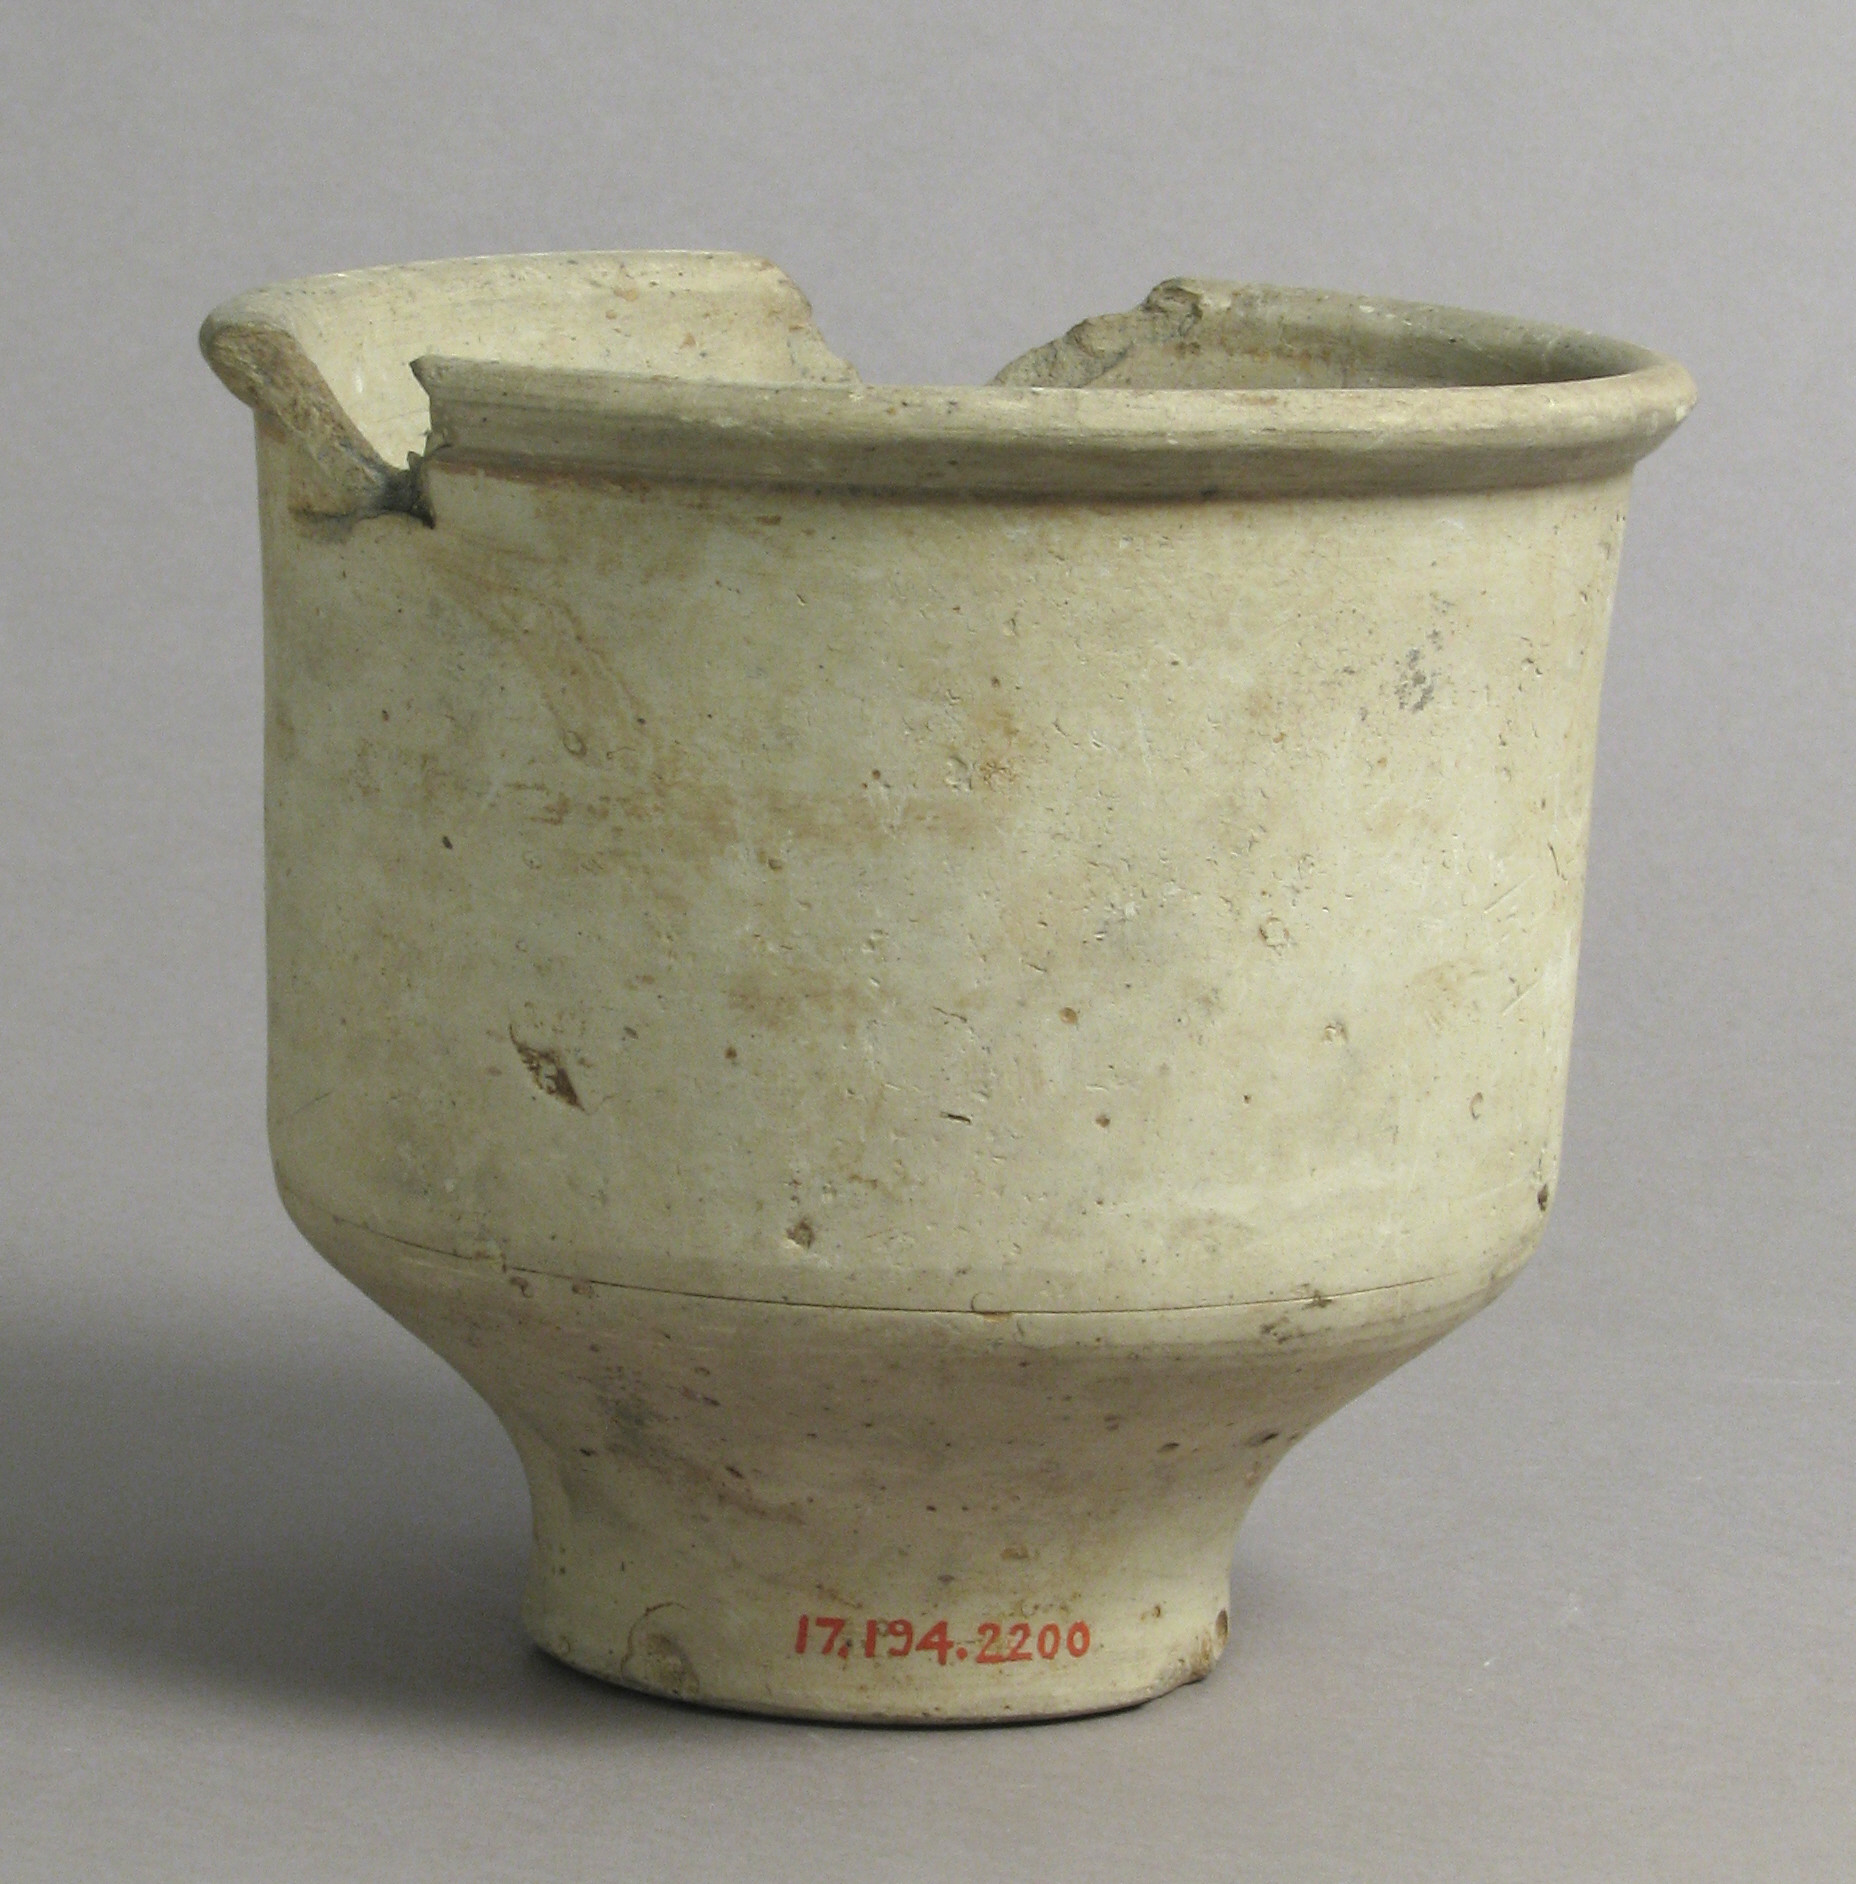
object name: pot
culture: french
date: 1401-1500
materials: earthenware